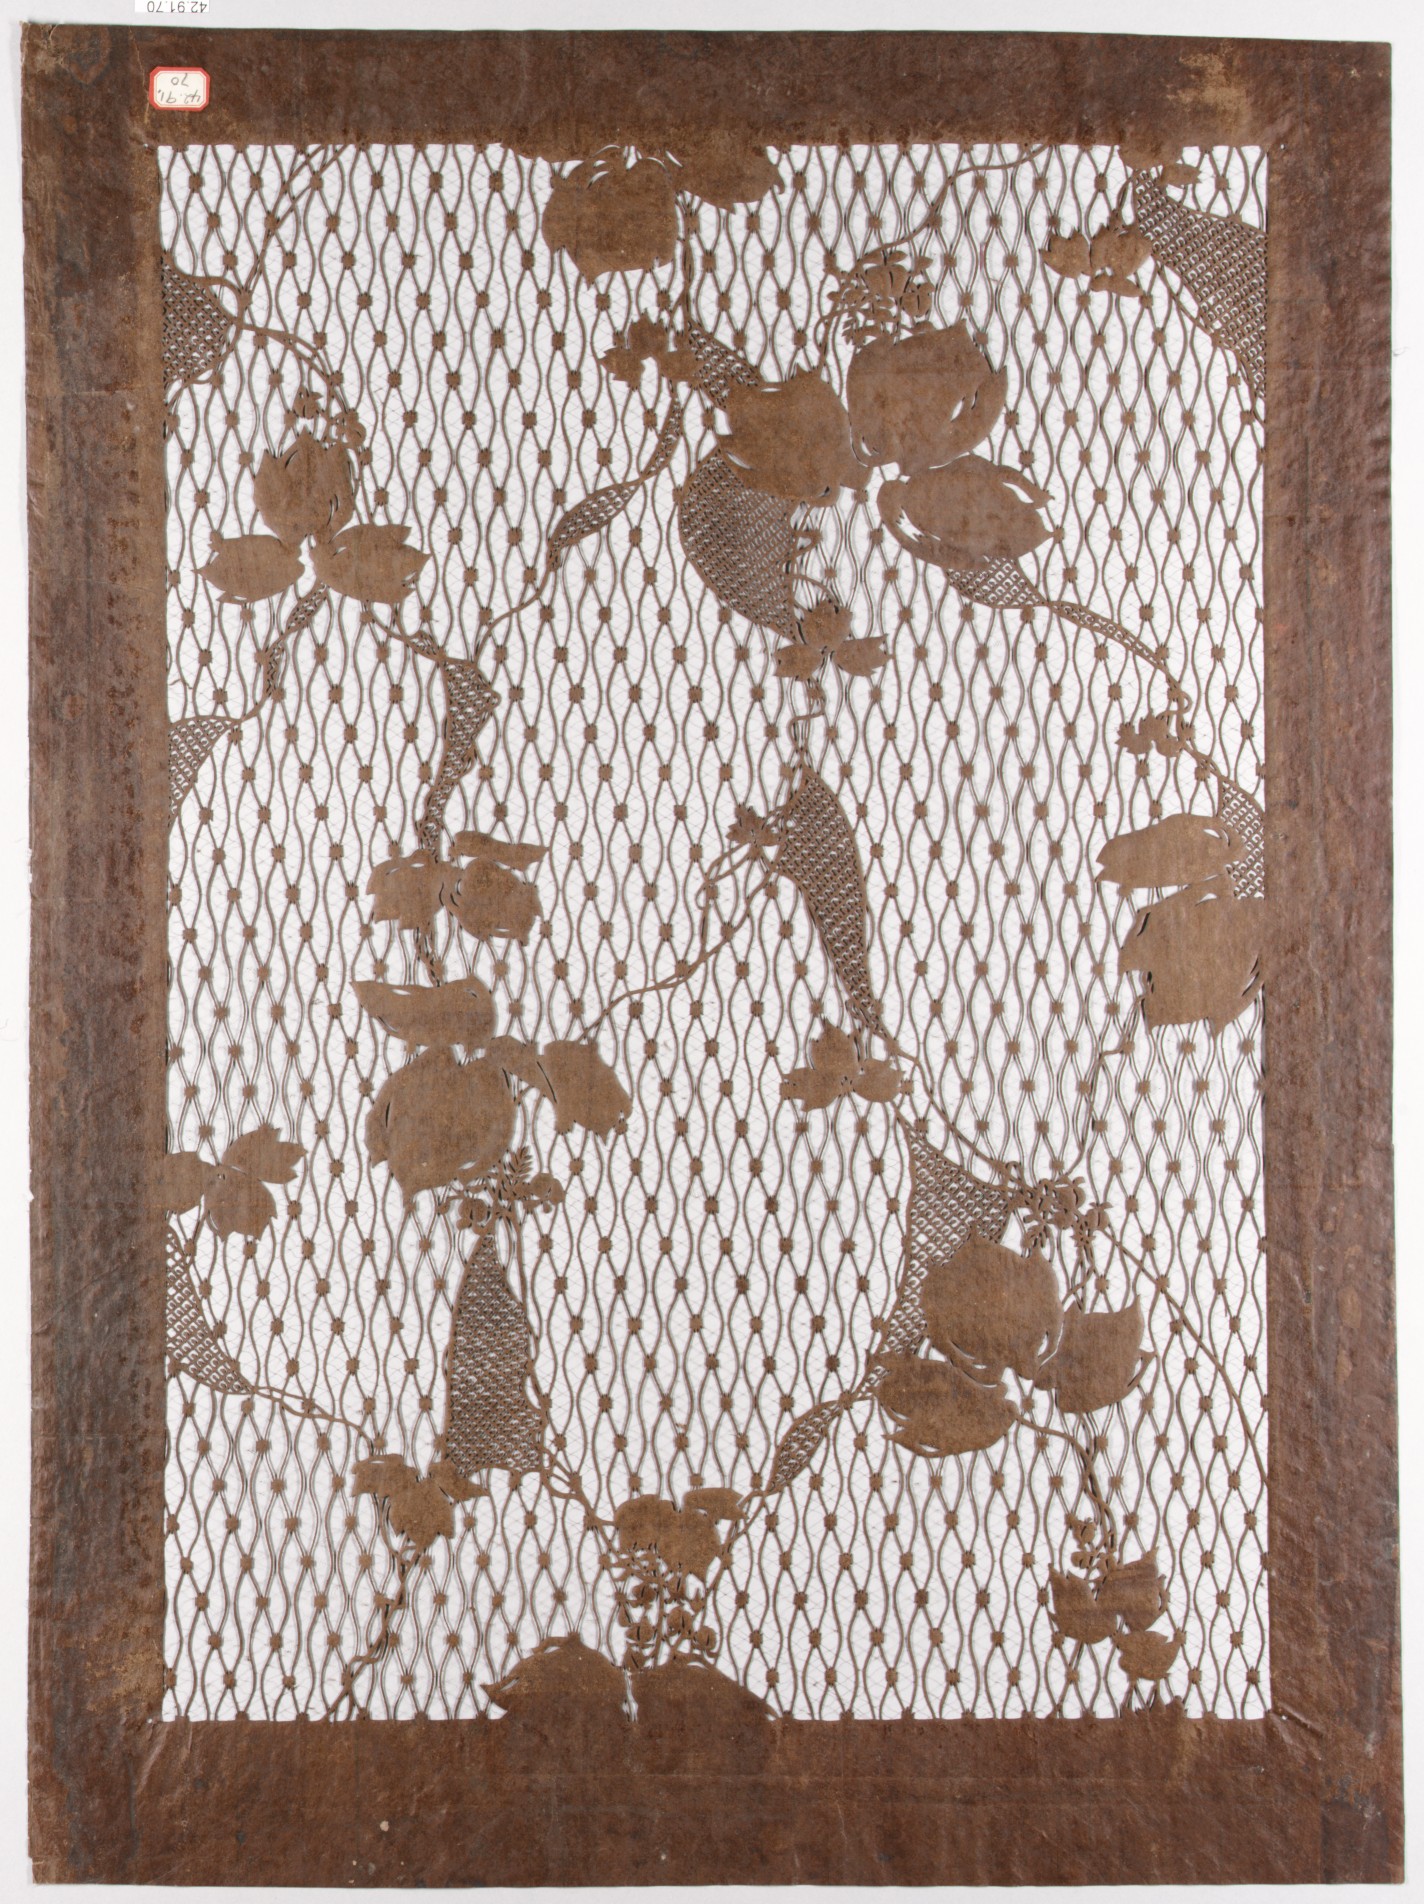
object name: stencil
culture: japanese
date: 1801-1900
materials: paper, silk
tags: flowers